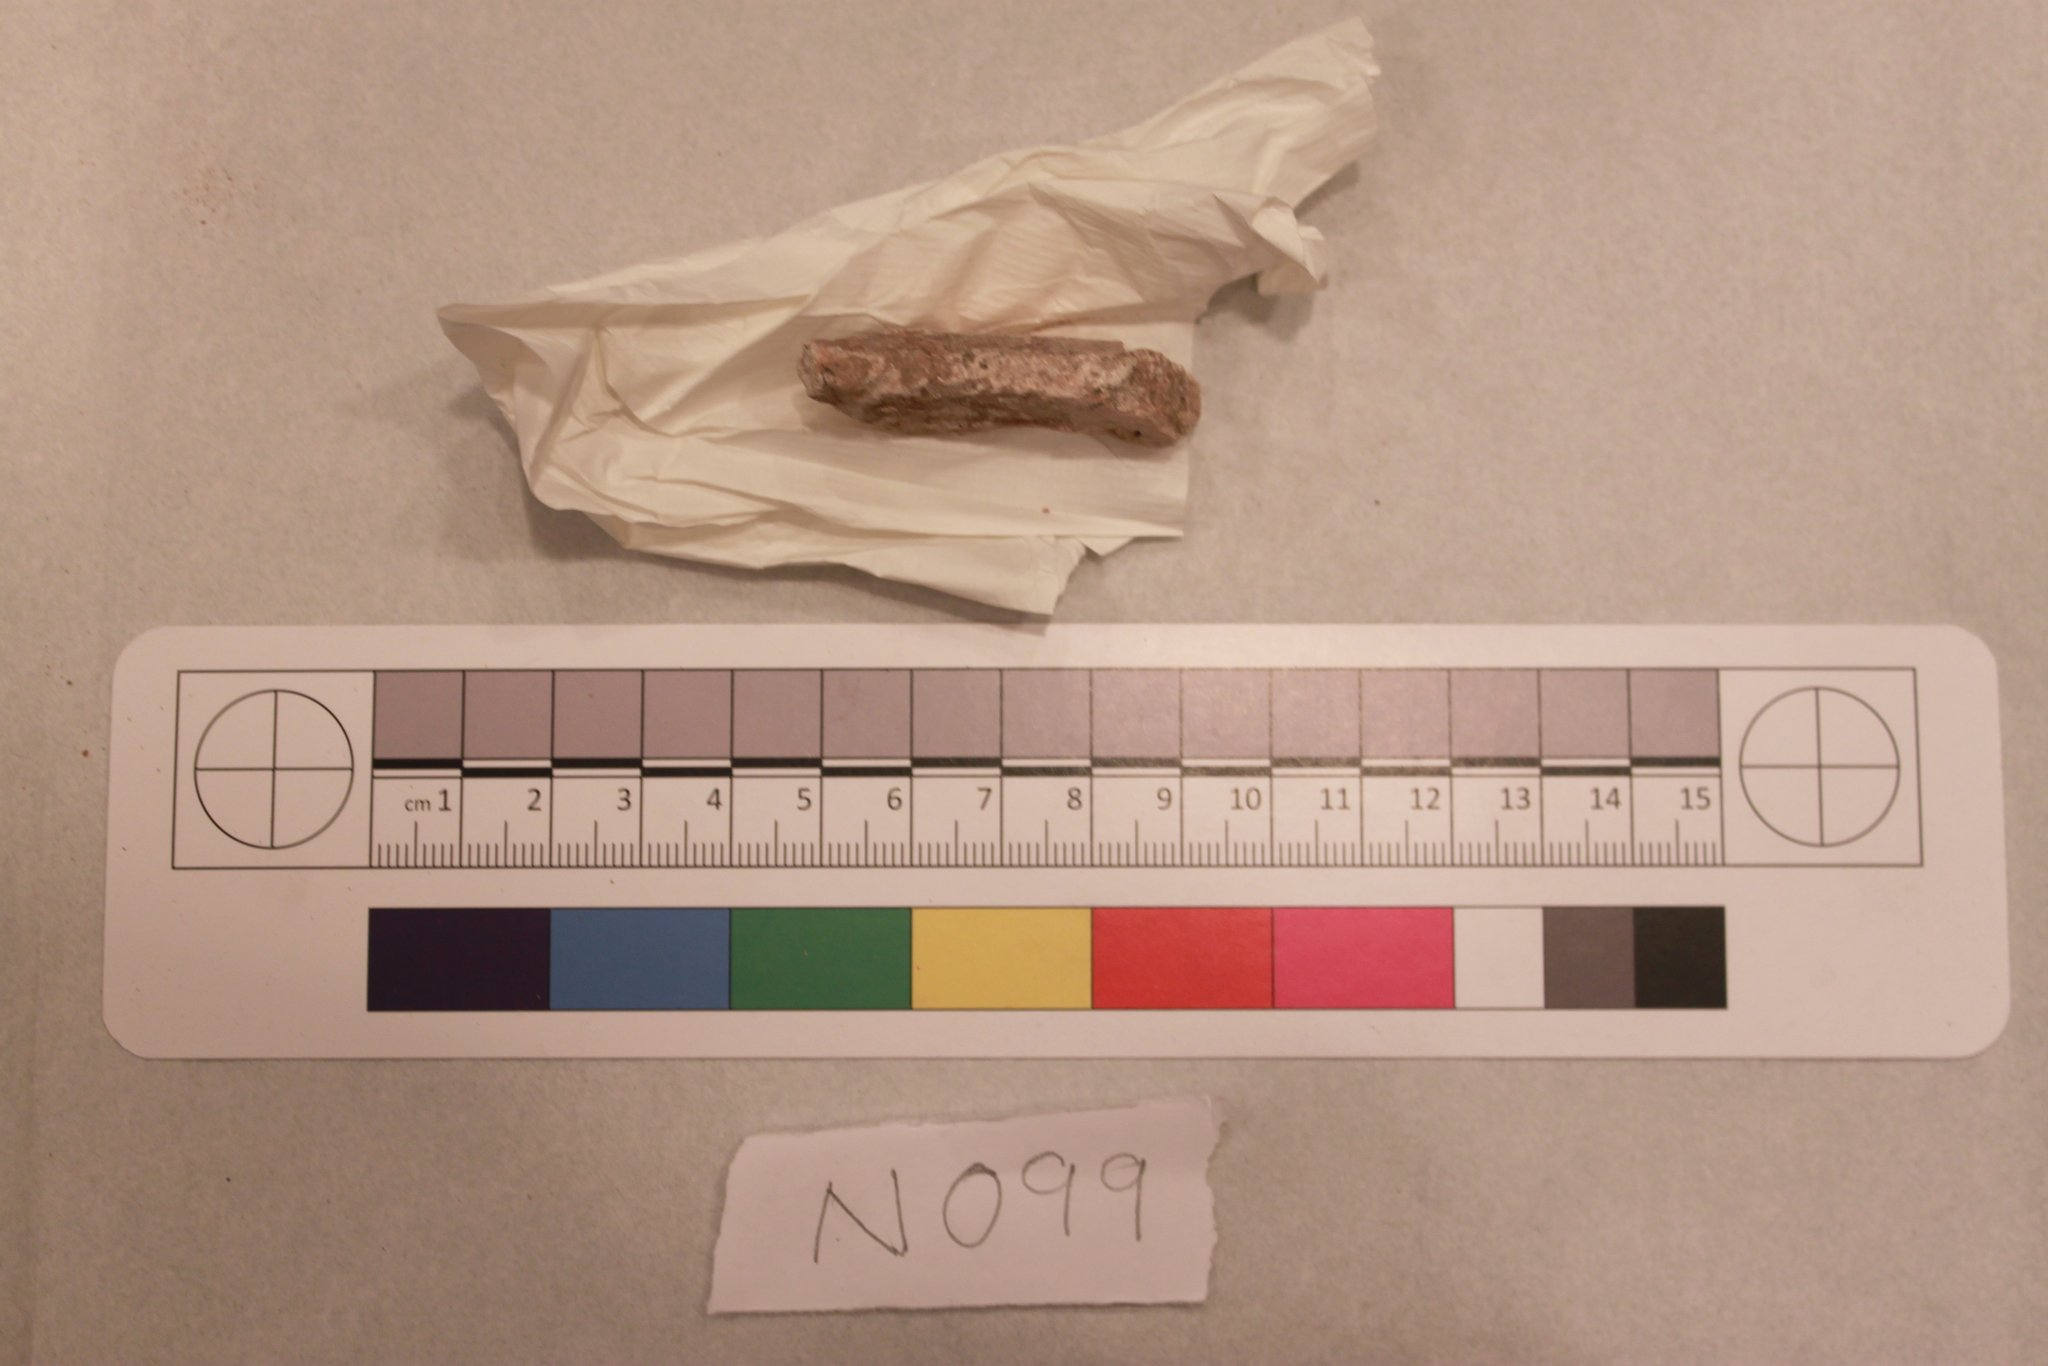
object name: fragment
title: Stucco Fragment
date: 701-1200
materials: plaster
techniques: carving, painting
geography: iran